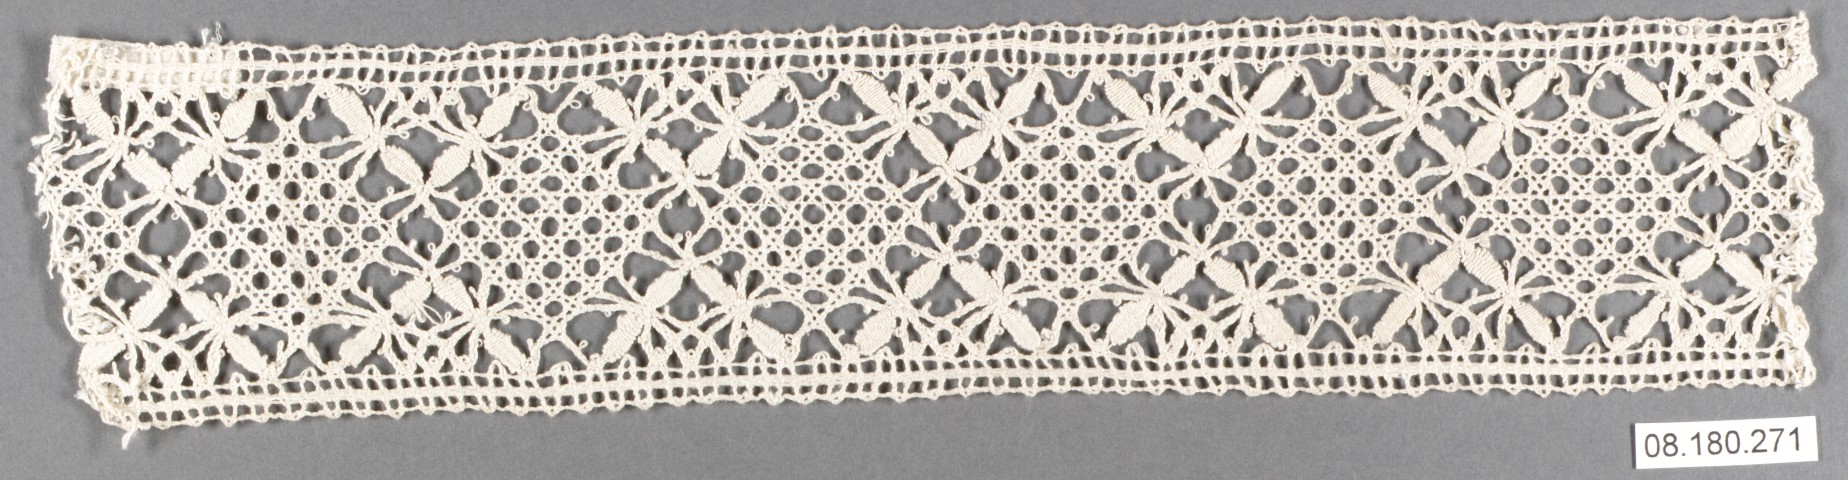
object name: insertion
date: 1805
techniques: lace